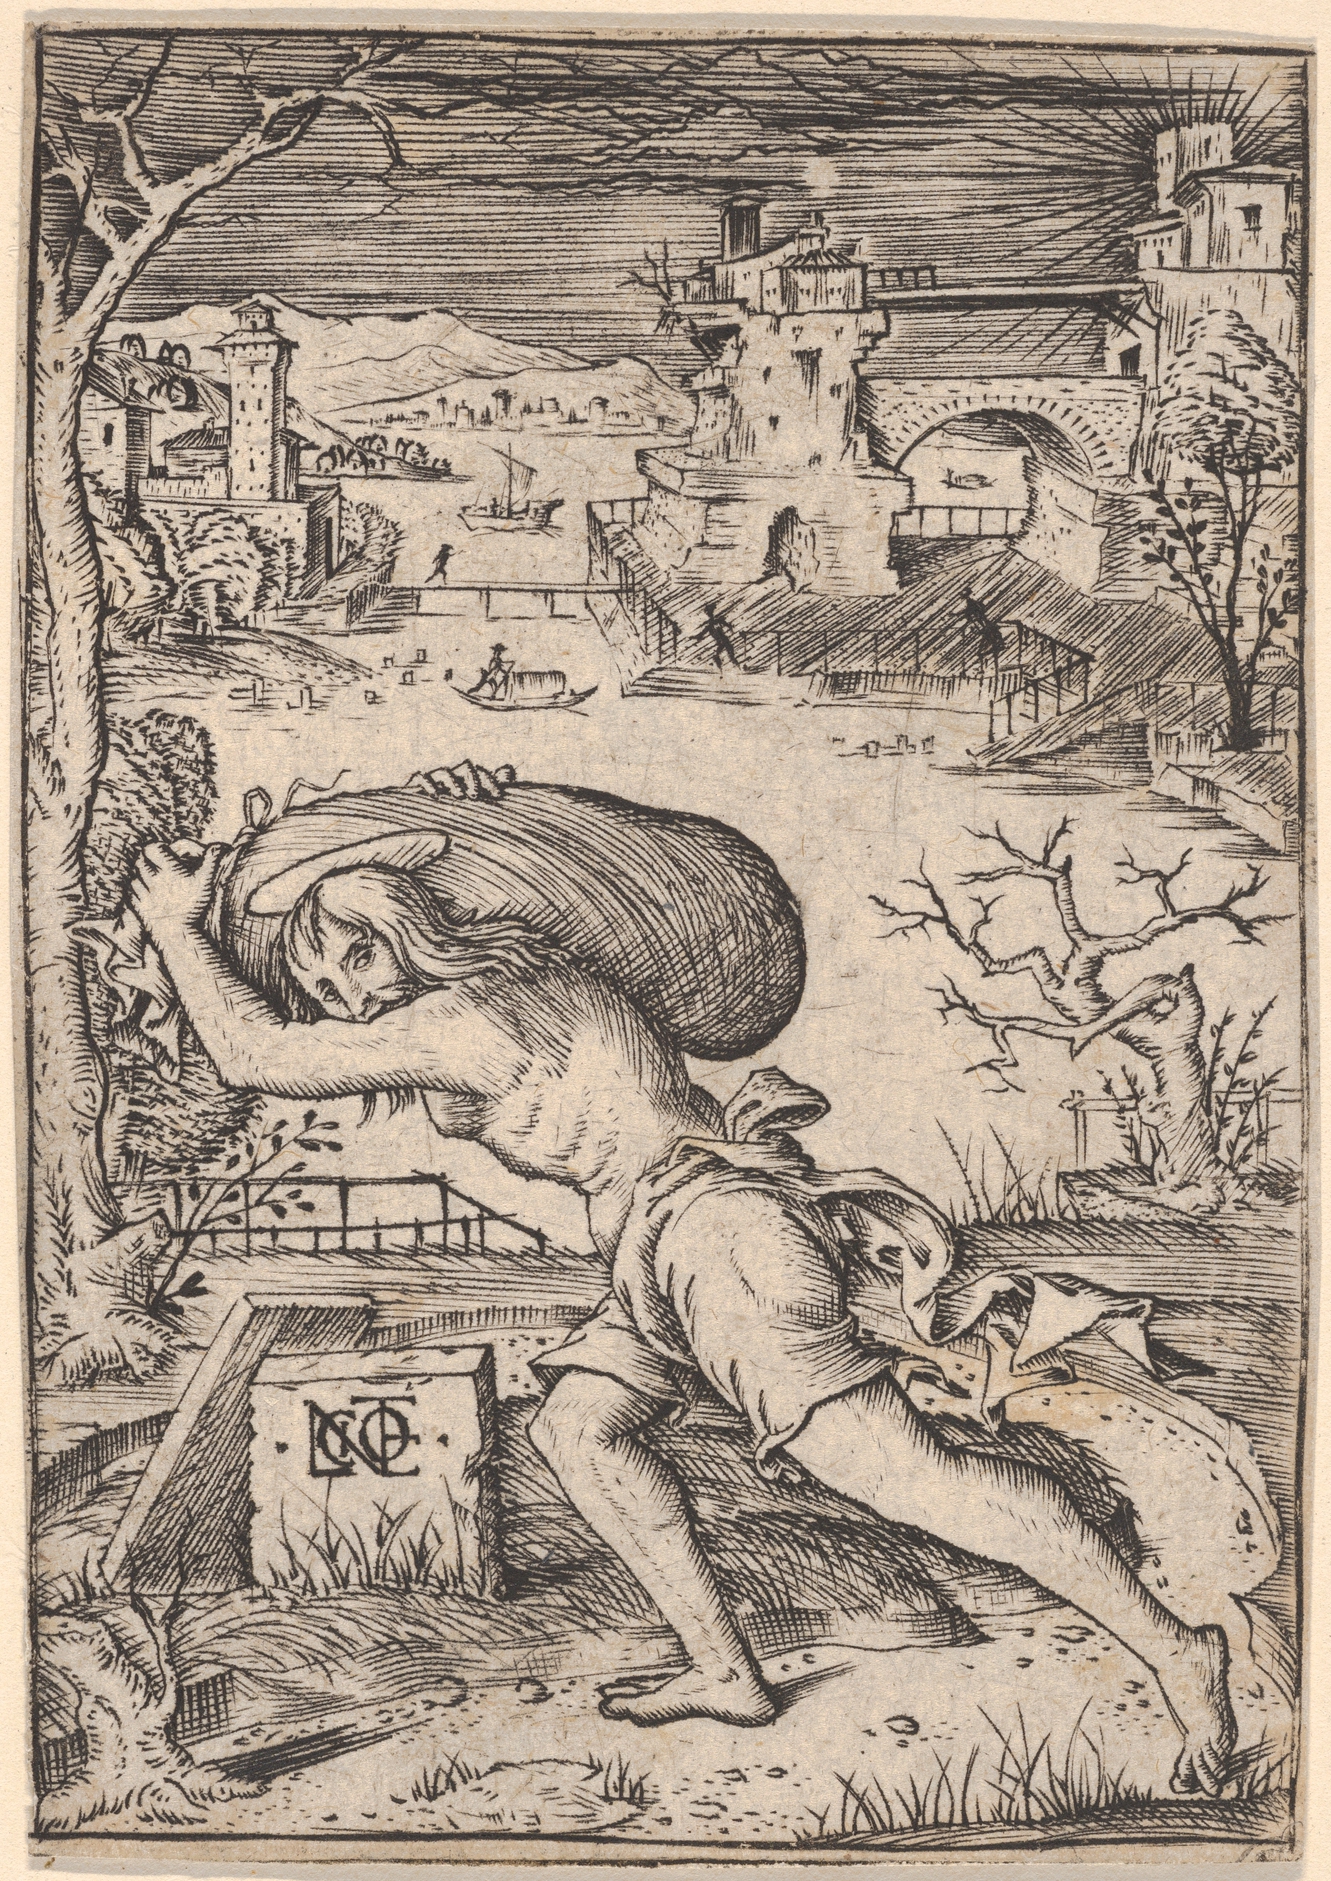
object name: print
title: A man carrying sack striding to the left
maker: nicoletto da modena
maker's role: artist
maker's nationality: italian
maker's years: 1500-1520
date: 1515-1520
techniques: engraving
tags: men,landscapes,working